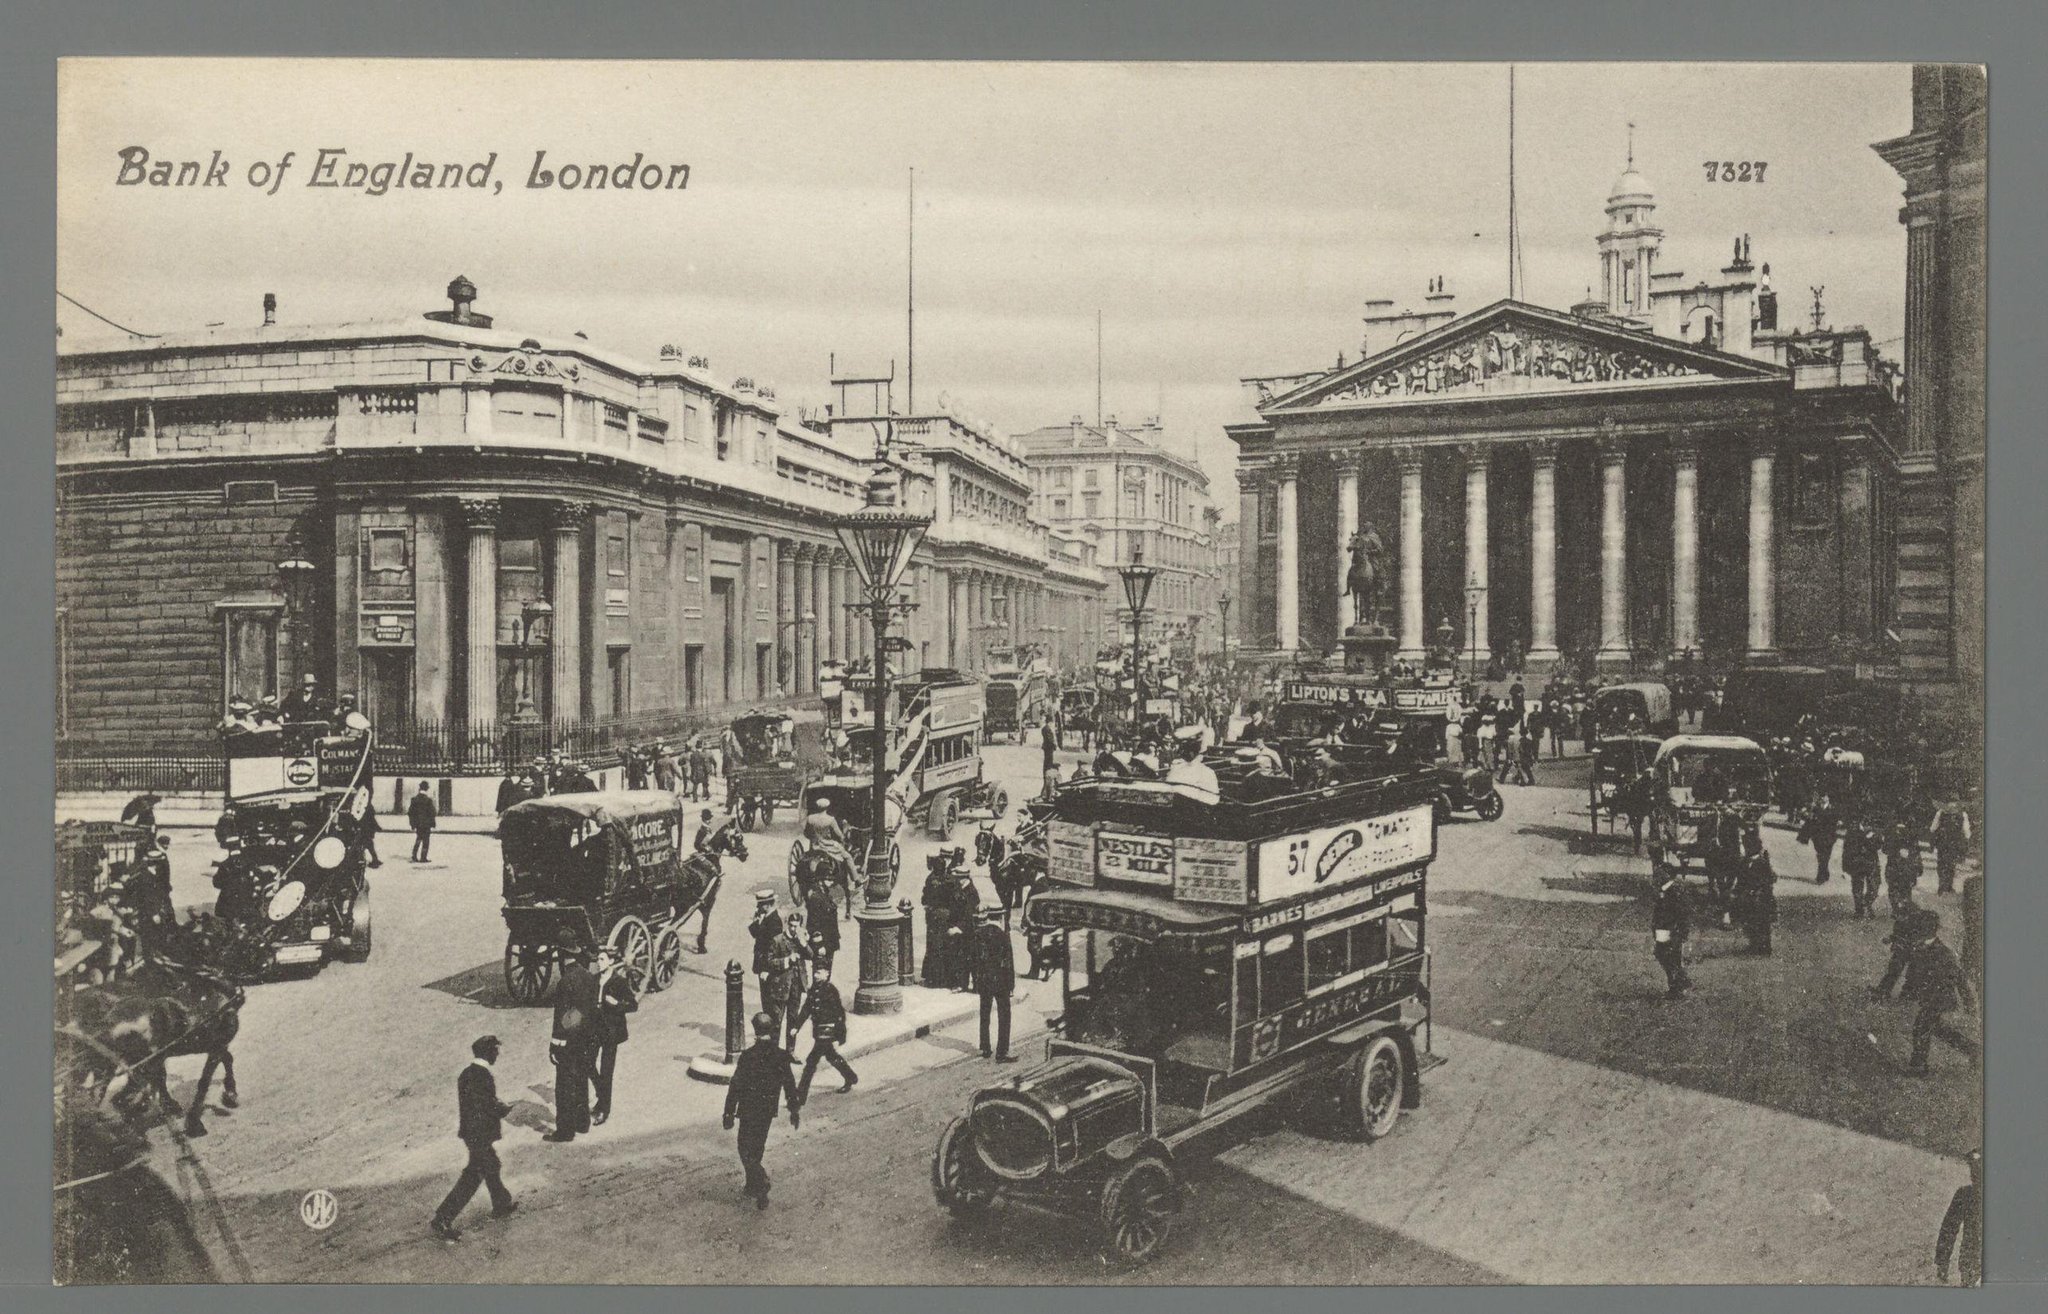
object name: photomechanical print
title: Bank of England, London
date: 1902-1930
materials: cardboard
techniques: photograph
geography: dundee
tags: square, place, circus, etc., diligence, omnibus, horse-tram, bank